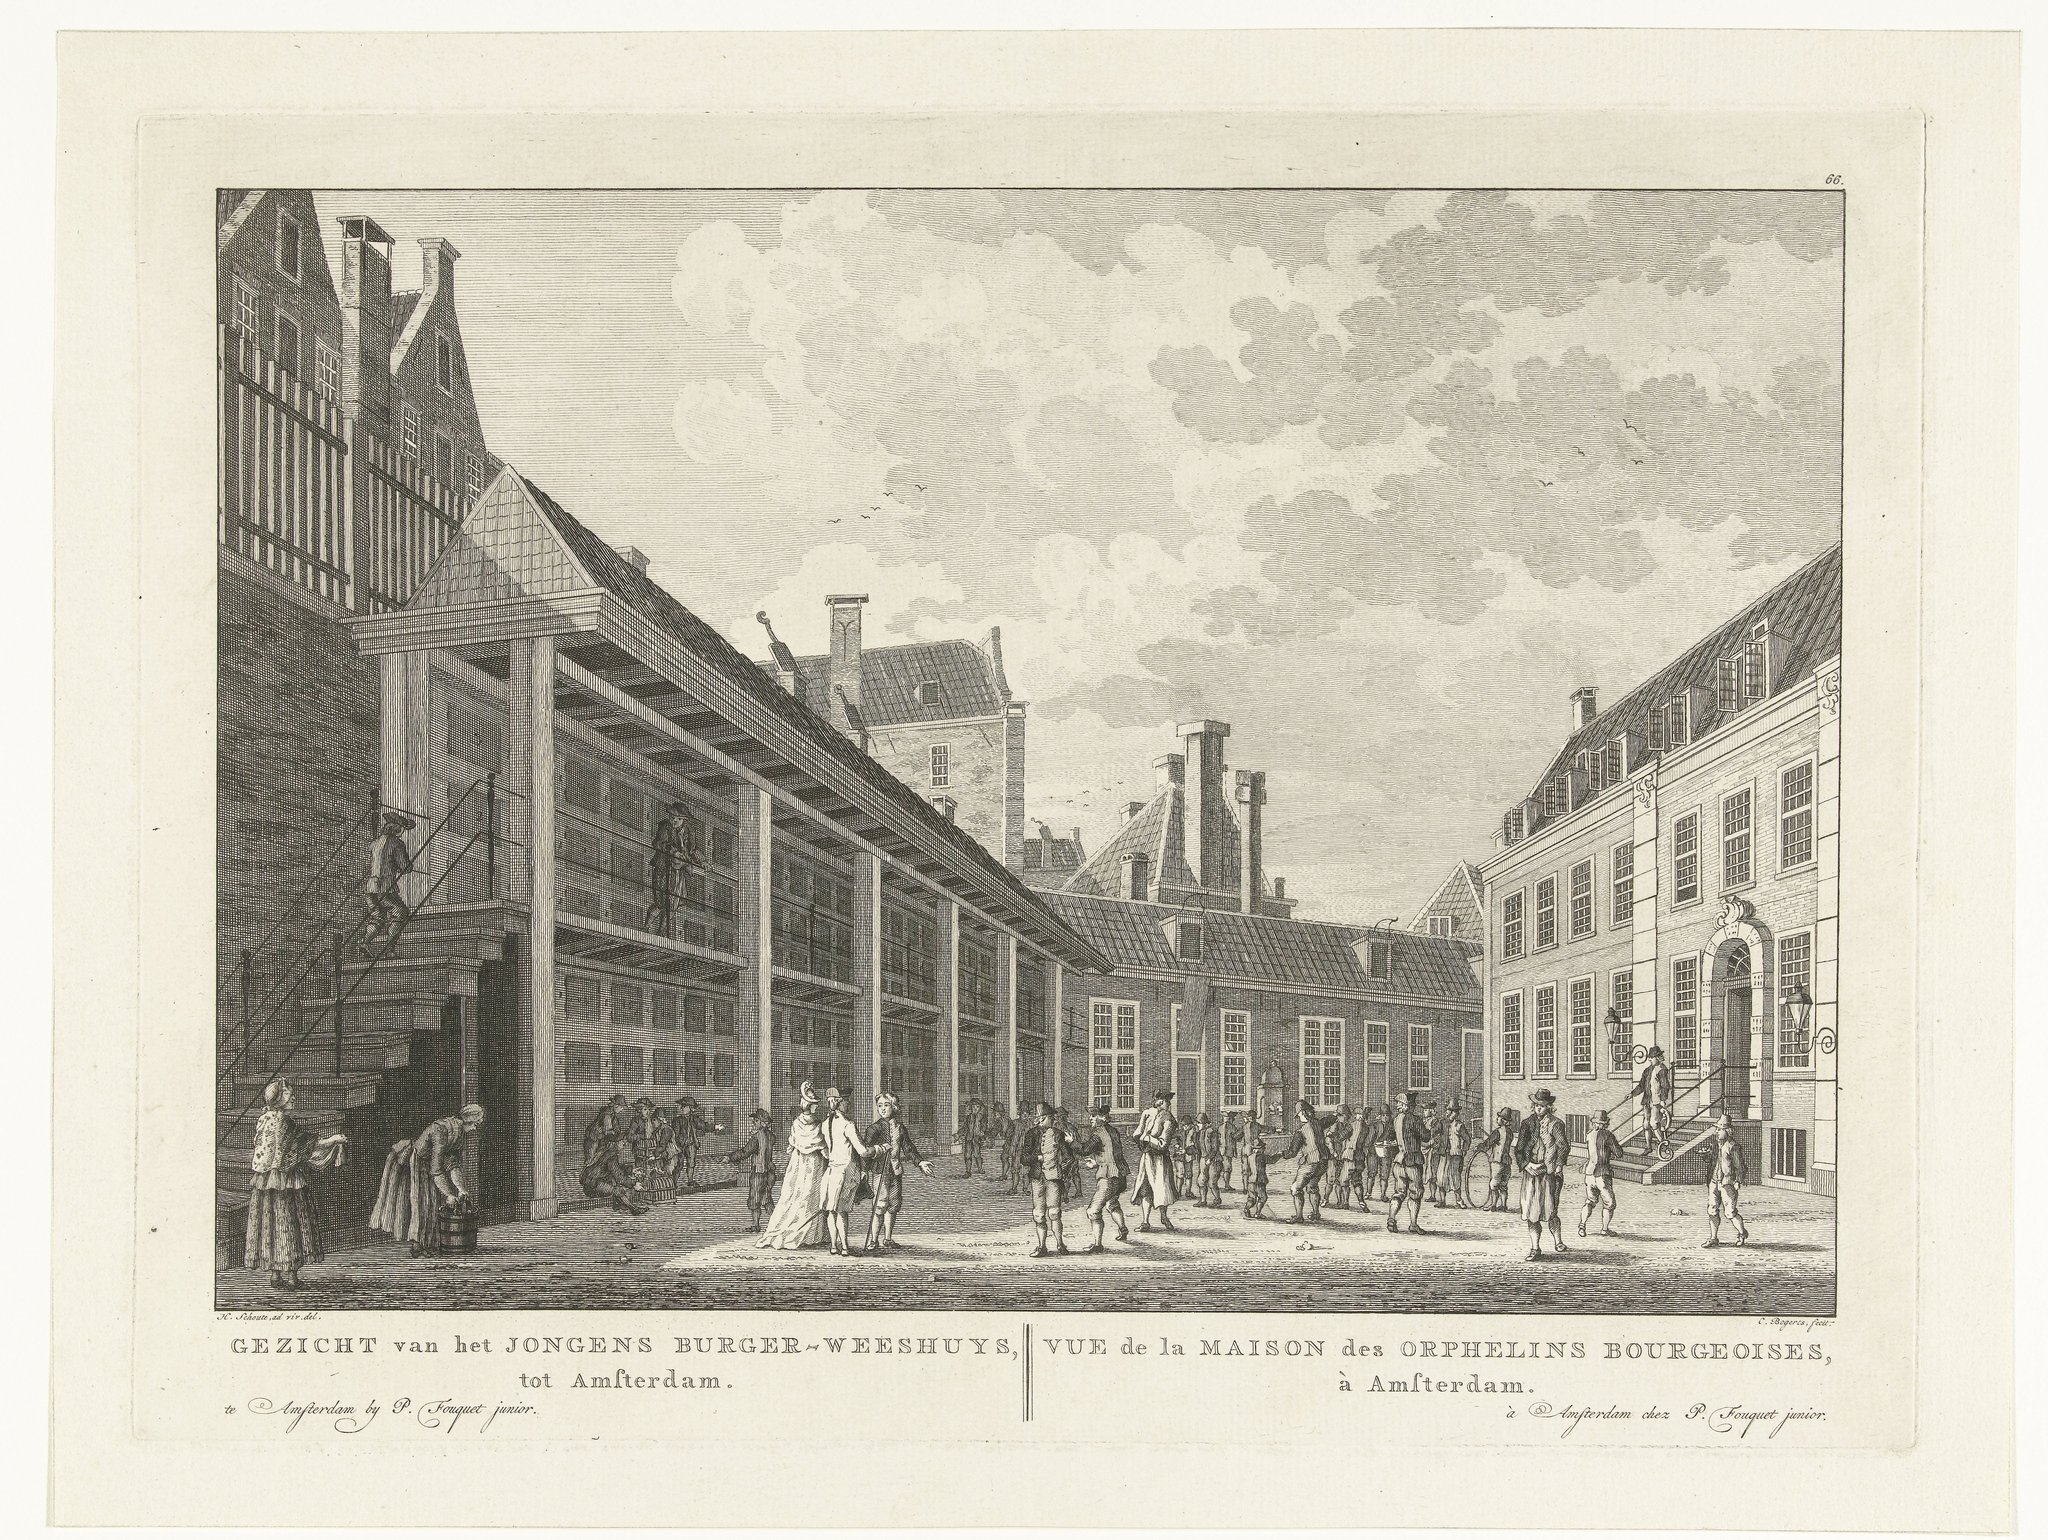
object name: print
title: Gezicht op het jongenshuis van het Burgerweeshuis te Amsterdam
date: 1770-1783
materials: paper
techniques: engraving, etching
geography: amsterdam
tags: public welfare, courtyard, orphanage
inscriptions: collector's mark: Lugt 2228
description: Deze prent is ook gebruikt in de zogenaamde Atlas van Fouquet.* Pierre Fouquet gaf vanaf 1760 stadsgezichten van Amsterdam - naar tekeningen van verschillende kunstenaars, gemaakt door verschillende prentmakers - uit. Deze prenten werden aanvankelijk los of in series verkocht. Zoals toen gebruikelijk kon de koper de prenten zelf laten inbinden. Hiertoe gaf Fouquet tussen 1778 en 1783 een titelblad, plattegrond en inhoudsopgave van de tot dusver 100 uitgegeven prenten uit (1). Gezien de inhoud afhankelijk was van wat de koper had verzameld verschilt de inhoud van de verschillende bewaarde Fouquetatlassen onder deze titel sterk. Ook zijn er exemplaren bekend waar tevens andere prenten aan zijn toegevoegd. Omdat er behoefte bleek aan uitleg bij de platen werd in 1783 een nieuwe versie van de atlas uitgegeven, aangevuld met tekst en twee prenten. De aangegeven volgorde veranderde maar de platen van de al eerder uitgegeven prenten bleven ongewijzigd. Deze uitgave werd in opdracht van Fouquet gedrukt bij Daniël Jean Changuion en Petrus den Hengst (2). Een tiental platen werd bijgewerkt en verscheen, met nieuw impressum, in het vervolg van Wagenaars geschiedenis van Amsterdam, uitgeven door Petrus Conradi en Folkert van der Plaats (3). Een aantal jaar na het overlijden van Fouquet kwam Evert Maaskamp met een nieuwe uitgave van de atlas, met verbeterde tekst en toevoeging van twee prenten. Op alle platen verwijderde hij het oude en liet hij zijn eigen impressum zetten (4). De huidige staat van de prent komt voor in exemplaren van de onder (1) en (2) genoemde werken. * Onder de Atlas van Fouquet of Fouquetatlas verstaan we de hieronder vermelde publicaties (1), (2) en (4). (1). Afbeeldingen van de wyd-vermaarde koopstad Amsterdam benevens des zelvs voornaamste gebouwen en gezigten alle naar het leeven getekend / Receuil des edifices les plus considerables et des plus belles vues, de la fameuse ville d'Amsterdam, dessinées d'après nature. Amsterdam: Pierre Fouquet, 1778-1783. (2). Nieuwe atlas, van de voornaamste gebouwen en gezigten der stad Amsterdam, met derzelver beknopte beschryvingen. 2 delen. Amsterdam: Daniël Jean Changuion en Petrus den Hengst [in opdracht van Pierre Fouquet], 1783. (3). Stijl, Simon. Amsterdam, in zyne geschiedenissen, voorregten, koophandel, gebouwen, kerkenstaat, schoolen, schutterye, gilden en regeeringe, beschreeven. Om te dienen ten vervolge op het werk van Jan Wagenaar (…). 10 delen. Amsterdam en Harlingen: Petrus Conradi en Folkert van der Plaats, 1788-1801. (4). Nieuwe atlas, van de voornaamste gebouwen en gezigten der stad Amsterdam. Met derzelver beknopte beschryvingen. Amsterdam: Evert Maaskamp, 1805. * Het aantal vermelde staten is gebaseerd op het aantal gevonden staten. Mogelijk zijn er meer staten van deze prent.